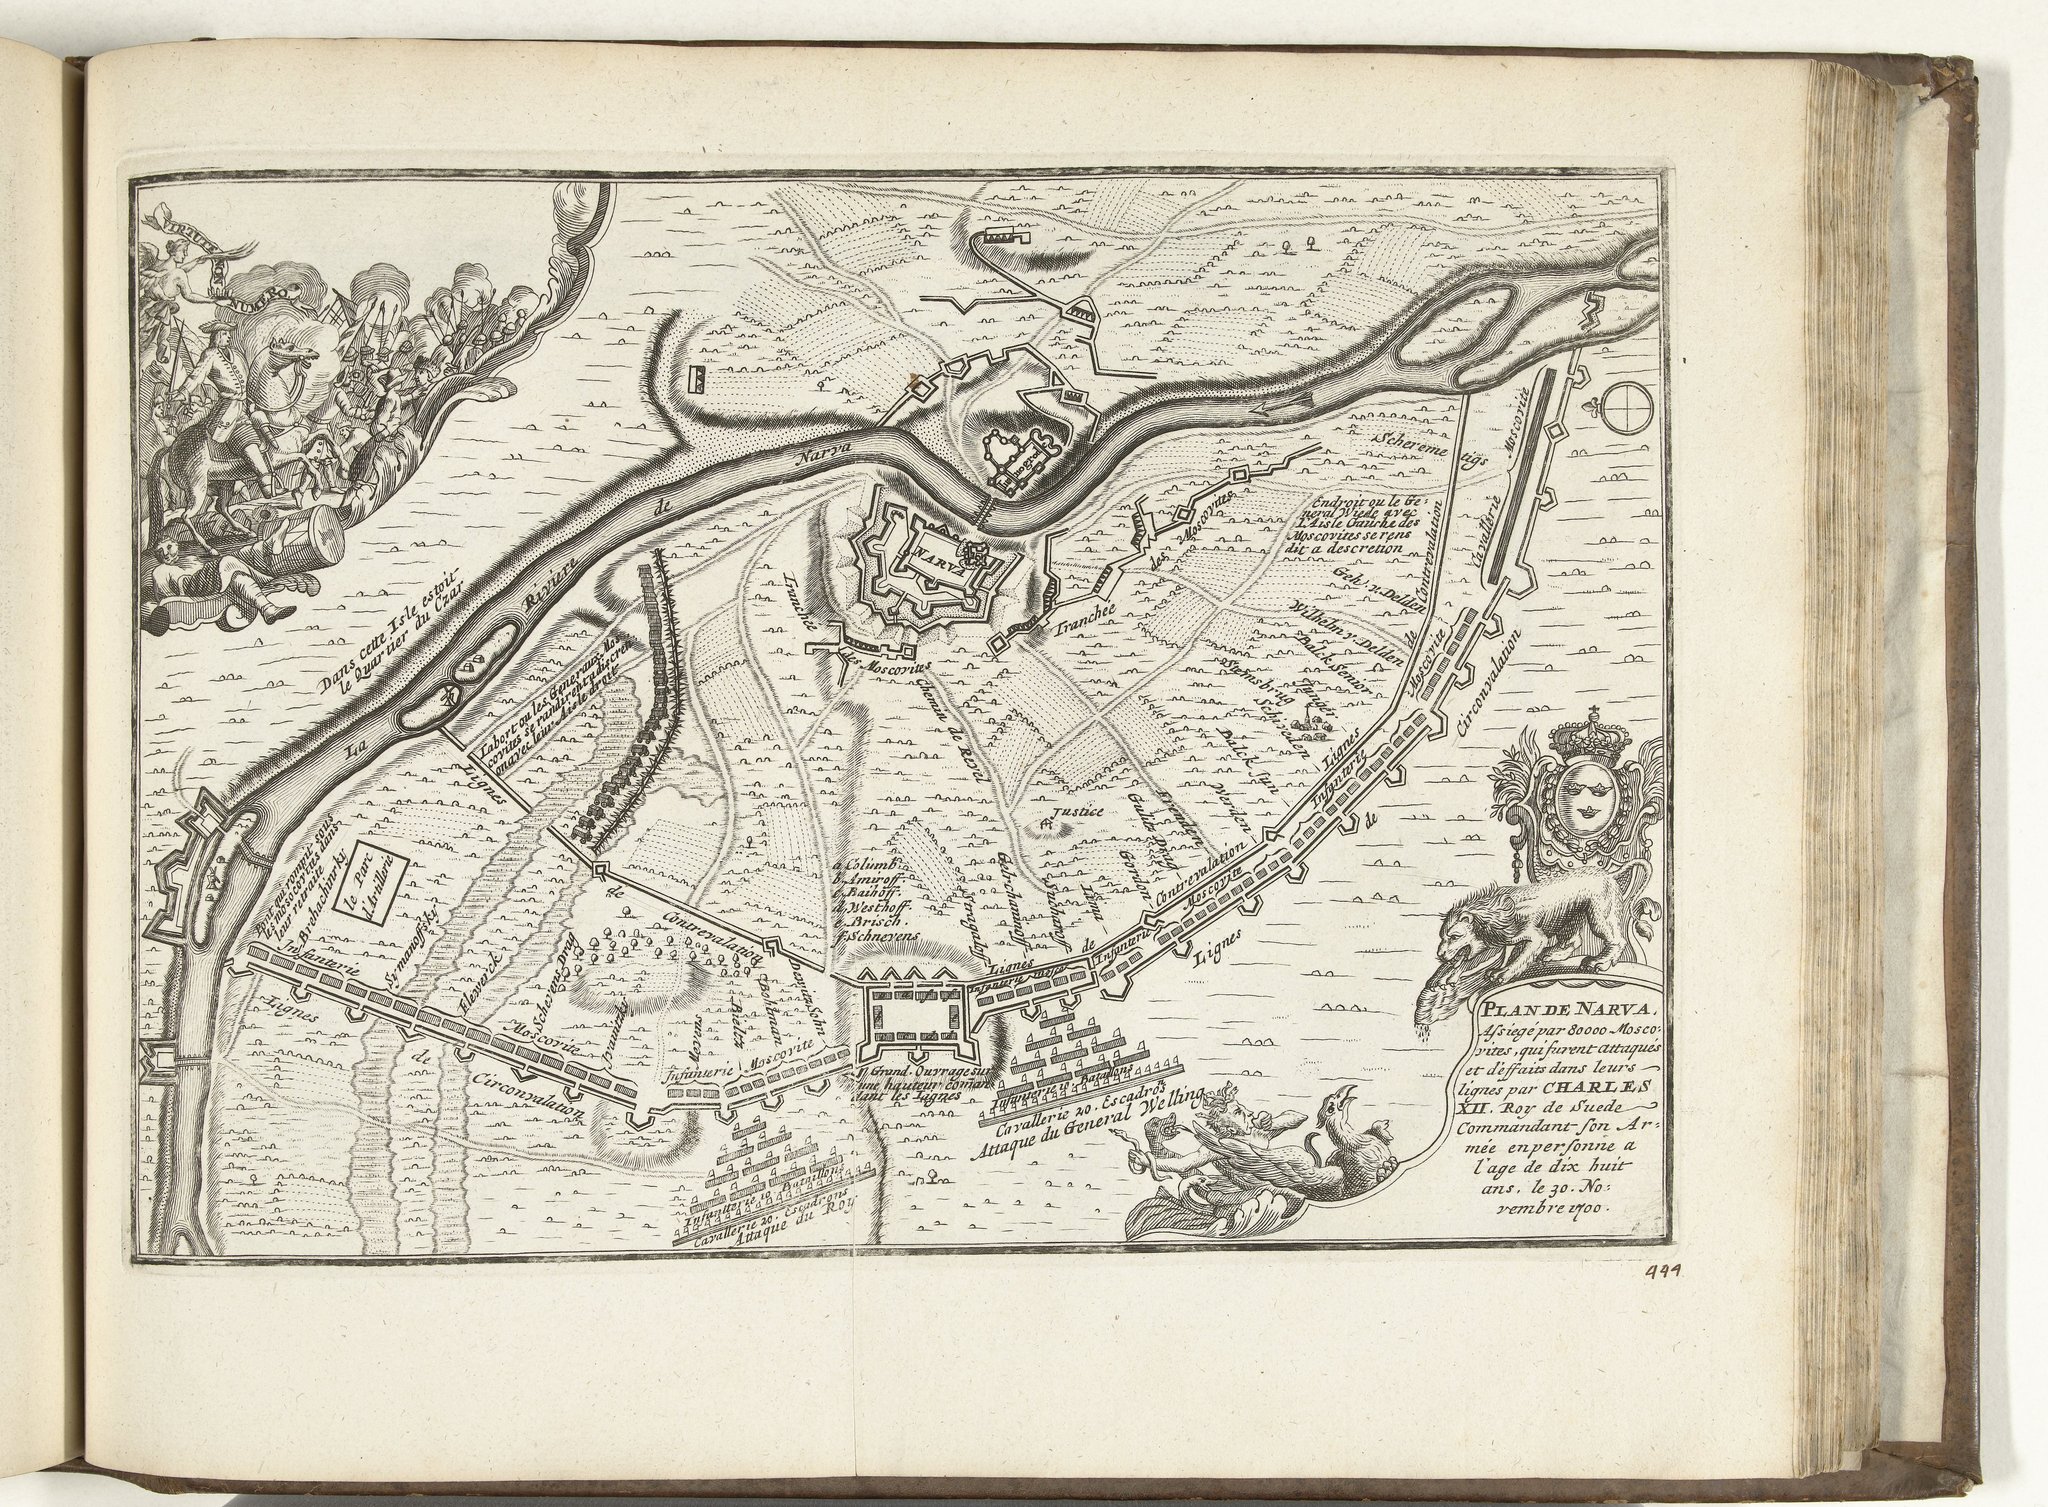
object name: print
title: Beleg en ontzet van Narva, 1700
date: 1726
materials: paper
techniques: engraving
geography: leiden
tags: peter i de grote (tsaar van rusland), raising the siege with outside assistance, relief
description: Narva in Estland belegerd door het Russische leger onder tsaar Peter de Grote wordt ontzet door het Zweedse leger onder koning Karel XII, 30 november 1700. Plaat nr. 444 in deel XVIII van het prentwerk: Les Forces de l'Europe, Asie, Afrique et Amerique ... Comme aussi les Cartes des Côtes de France et d'Espagne uit 1726, dit tweede deel met 271 met de hand genummerde platen van vermaarde sterke steden en vestingen in het kader van de Spaanse Successieoorlog 1701-1713. Voor het merendeel zijn deze platen gekopieerd naar de anonieme Franse platen van vermaarde sterke steden en vestingen: in Les forces de l'Europe en in: Le theatre de la guerre, dans les Pays-Bas, beide oorspronkelijk uitgegeven door Nicolas de Fer te Parijs (1693-1697) in het kader van de Negenjarige Oorlog. Titel en opschriften in het Frans.